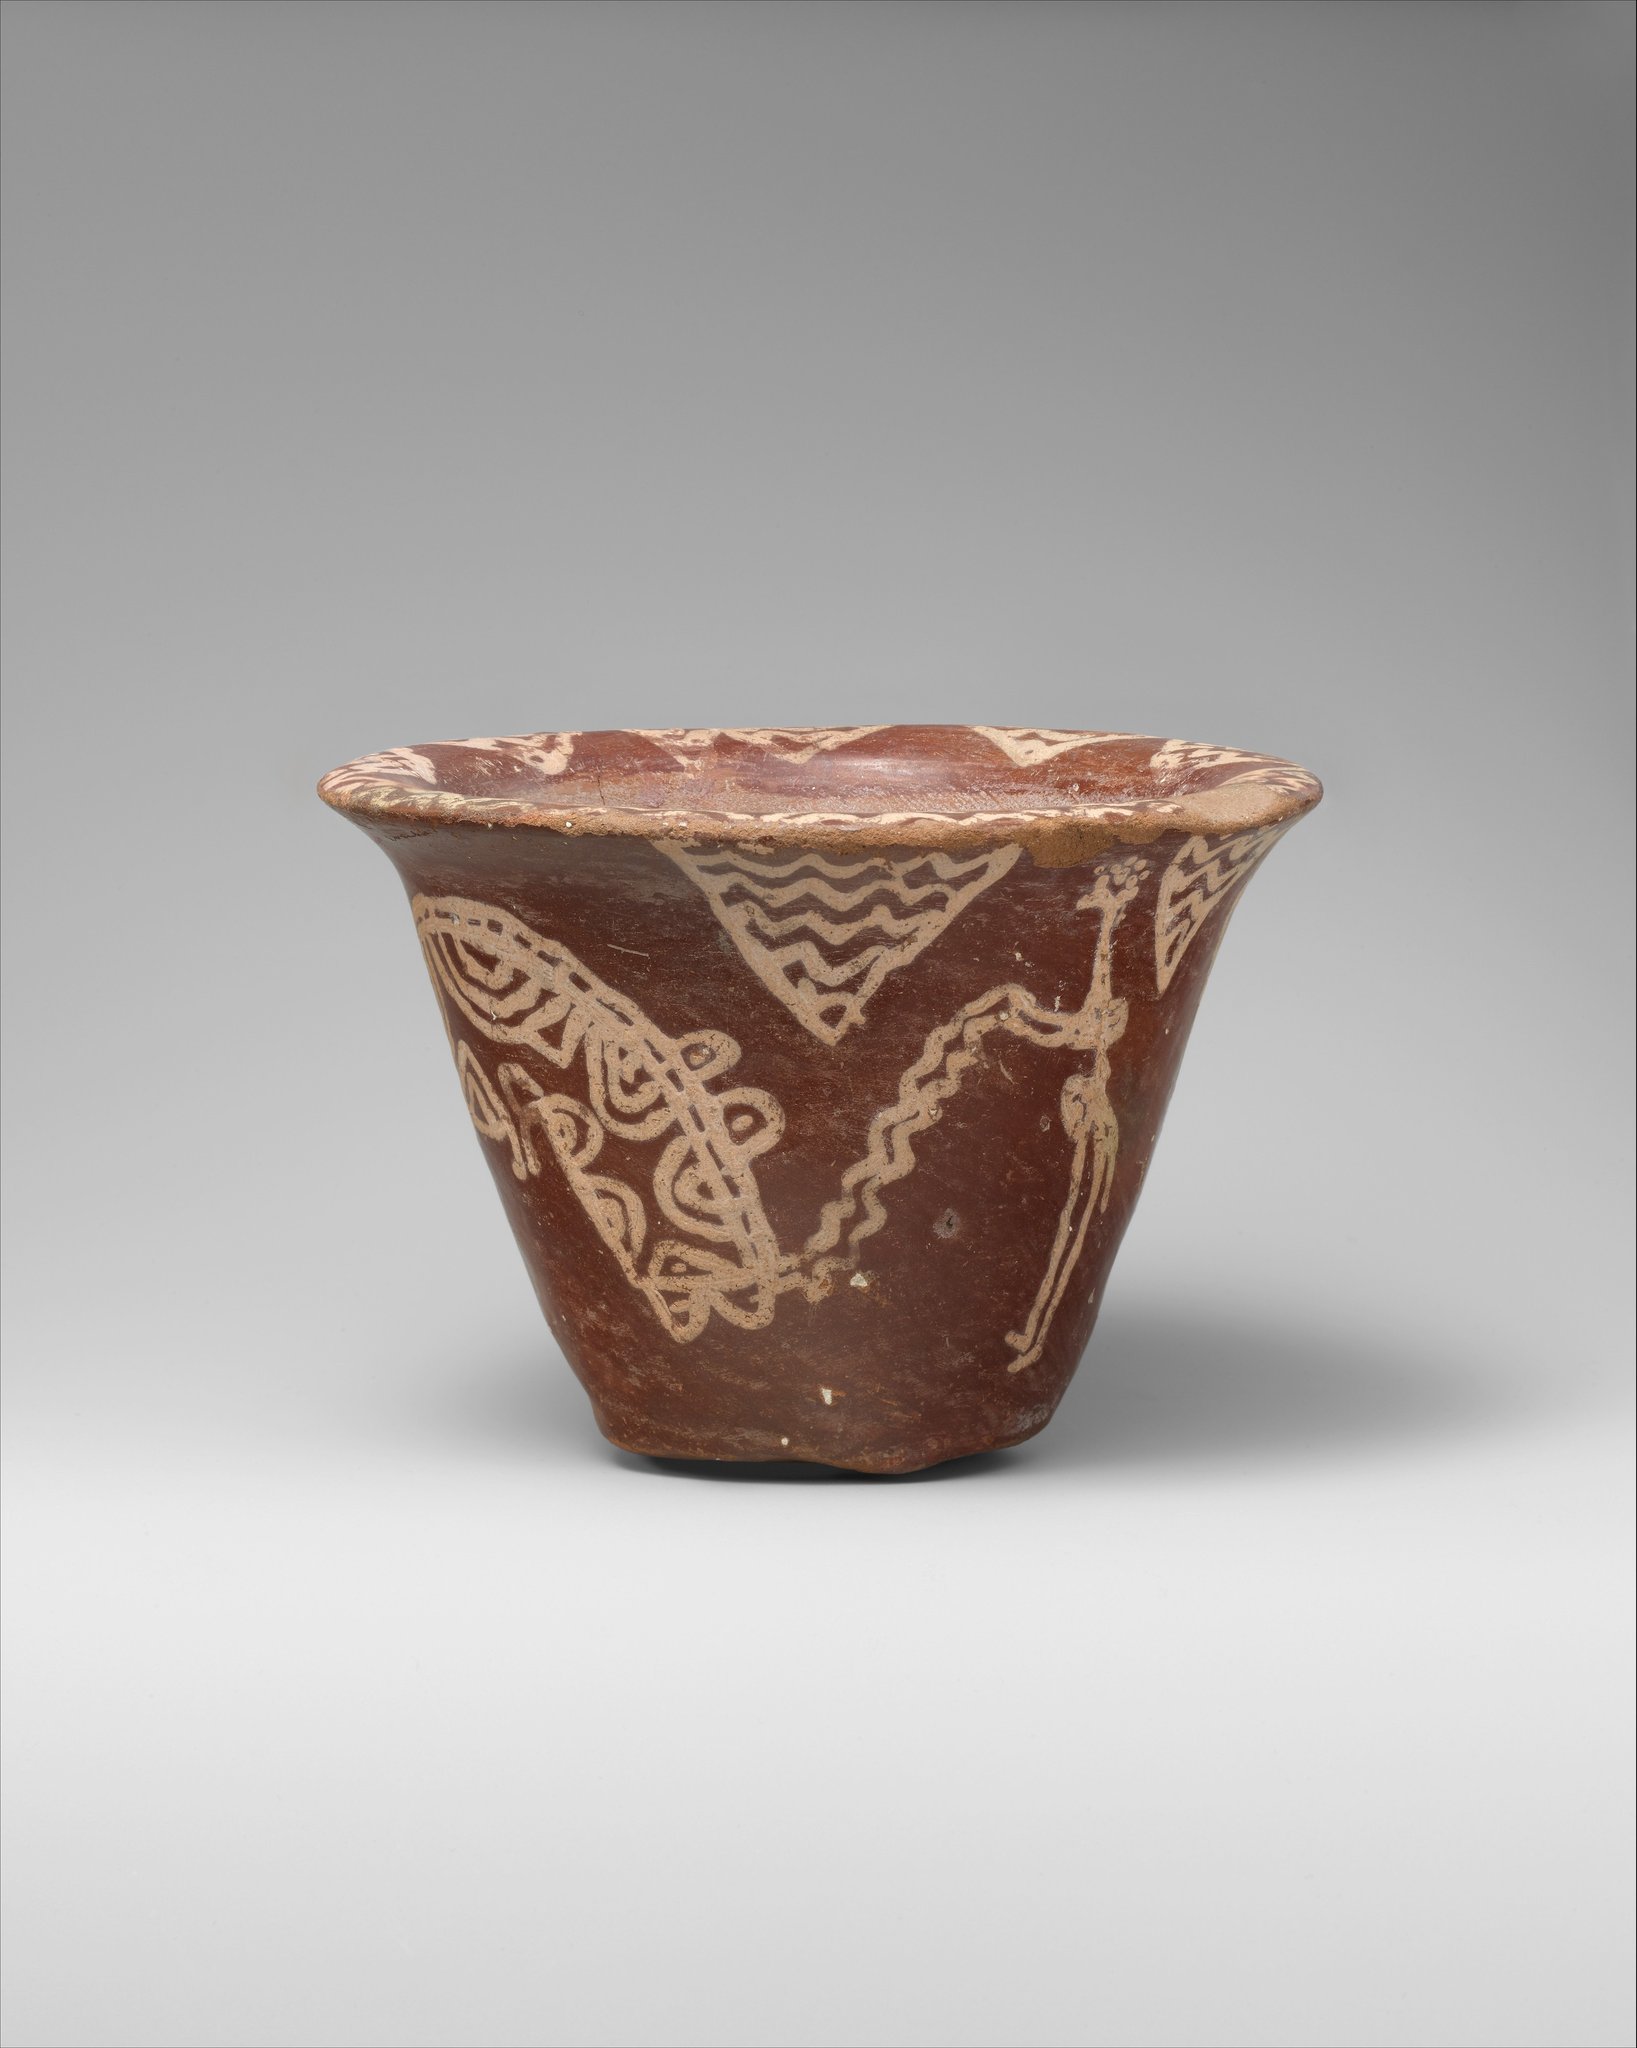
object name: bowl, white cross lined ware, man harpooning hippo, hunt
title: White cross-lined ware bowl illustrating a hippo hunt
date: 3700-3450 BCE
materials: paint, pottery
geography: egypt